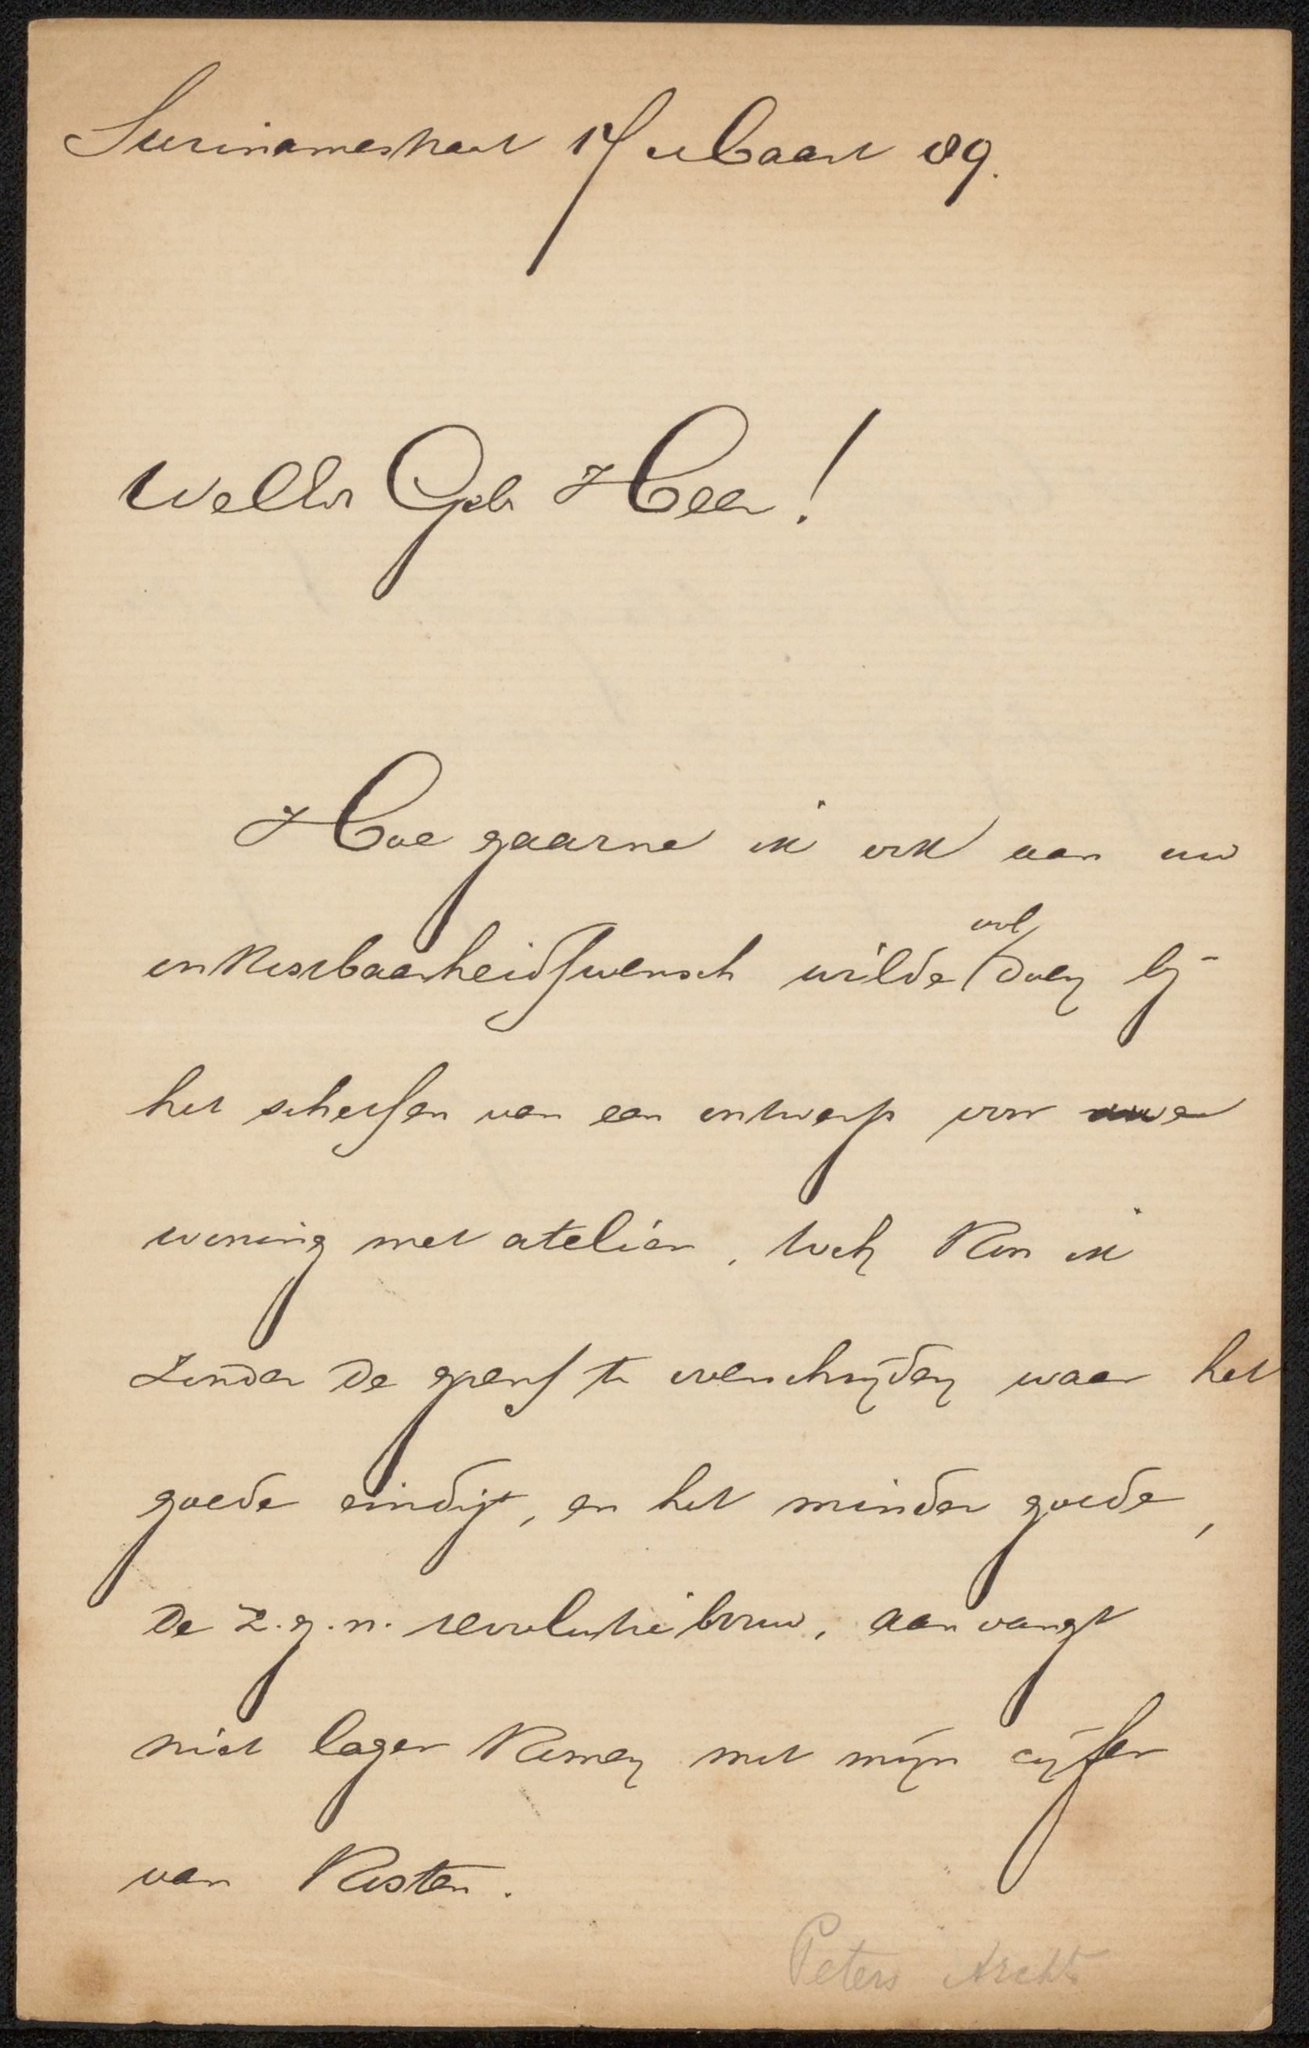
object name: letter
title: Brief aan Philip Zilcken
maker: c.h. peters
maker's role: architect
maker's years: 1847-1932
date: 1889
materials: ink, paper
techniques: pen, writing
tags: the hague, painter, draughtsman, philip zilcken, the graphic arts, workshop, studio of the artist (in general)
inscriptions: collector's mark: ‘RPK’